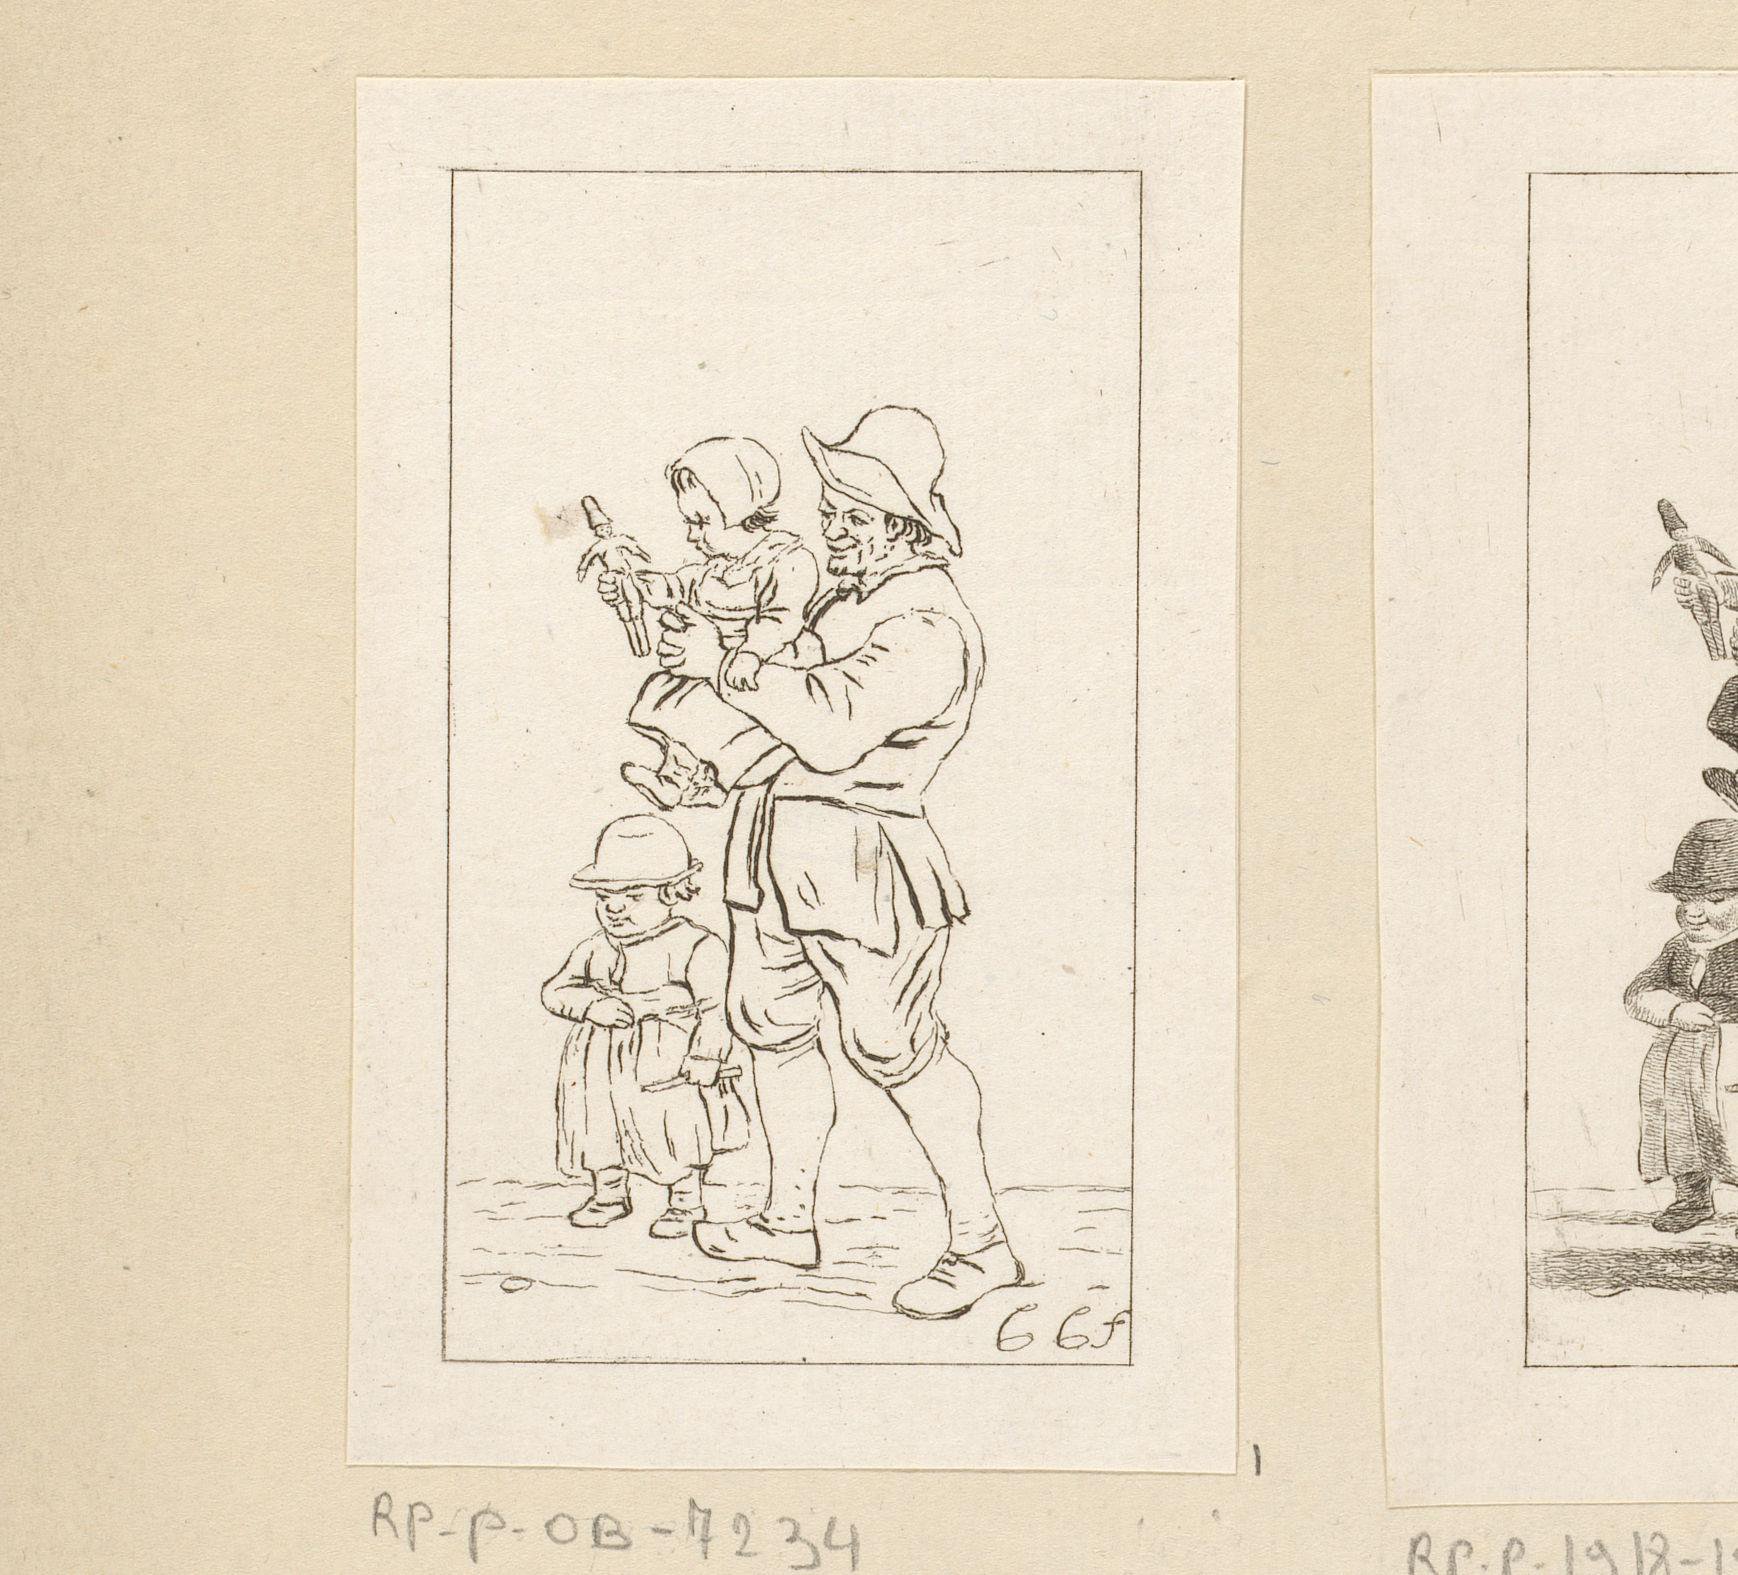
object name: print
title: Vader met twee kinderen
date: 1779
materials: paper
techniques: etching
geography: leiden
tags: father and child(ren), man and child(ren) (family group) (with number of children)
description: Een vader speelt met zijn twee kinderen. Een van de kinderen staat naast de man terwijl de andere wordt opgepakt door haar vader.